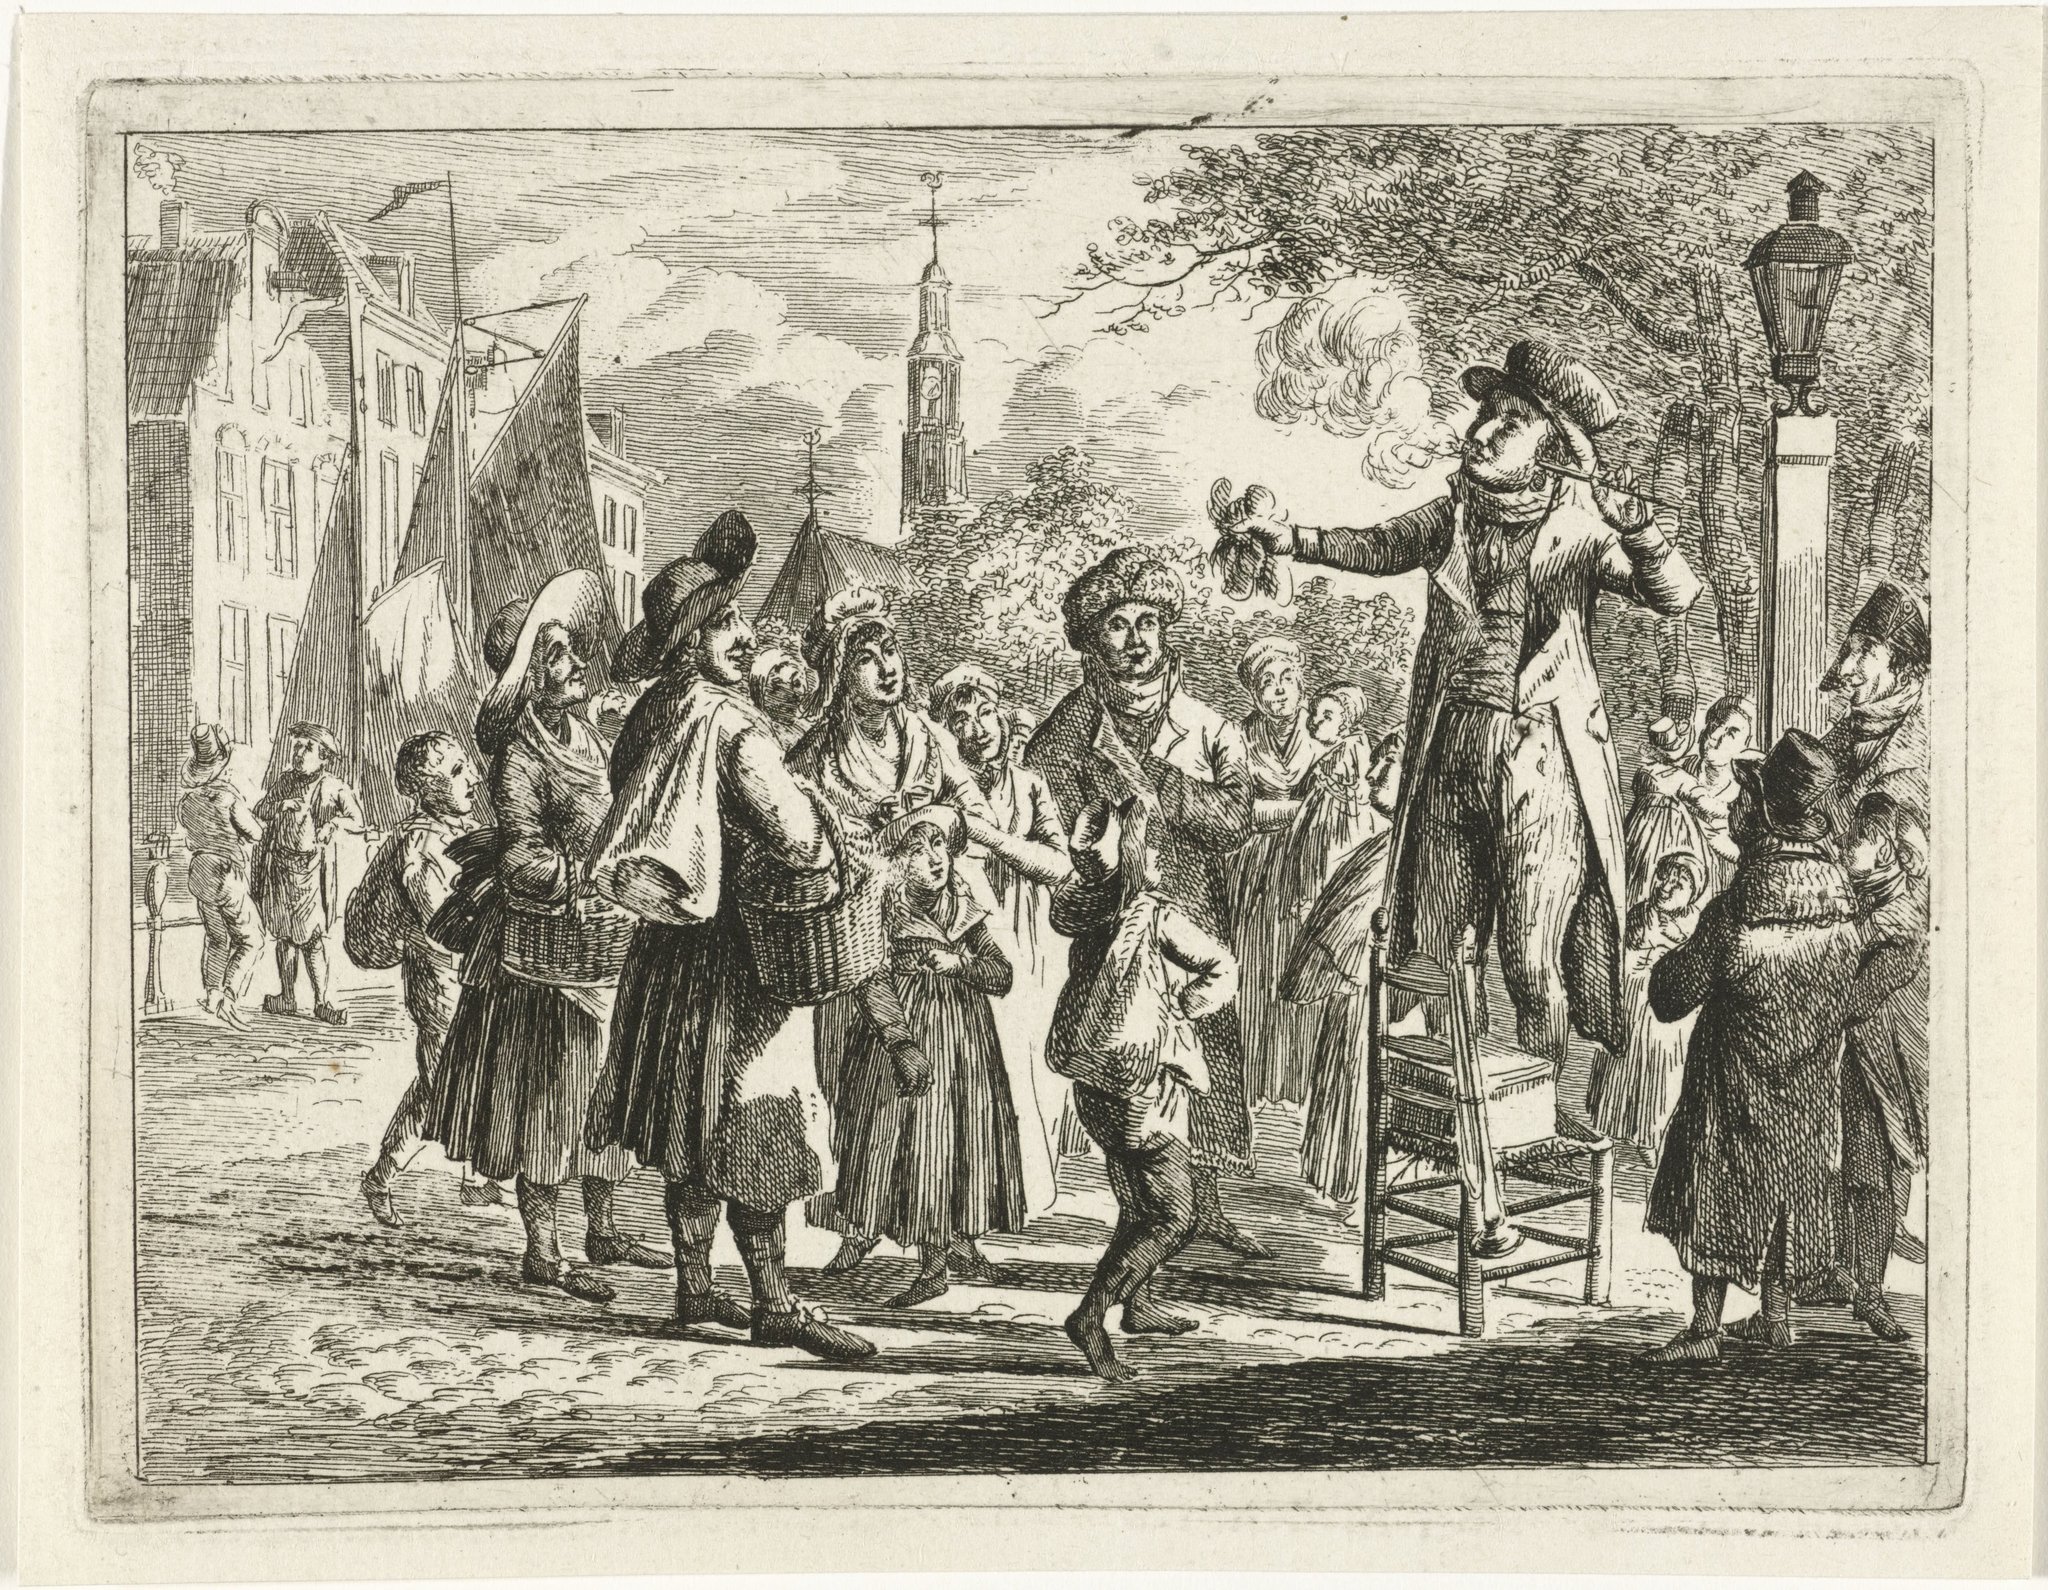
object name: print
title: Vuureter en zijn publiek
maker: christiaan meijer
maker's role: print maker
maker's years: 1782-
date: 1803-1808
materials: paper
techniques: etching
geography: rotterdam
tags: fire-eater, village street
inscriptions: collector's mark: Lugt 2228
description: De vuureter vertoont zijn kunst staande op een stoel. Om hem heen staan toeschouwers. Op de achtergrond een zeilschip en een kerktoren.